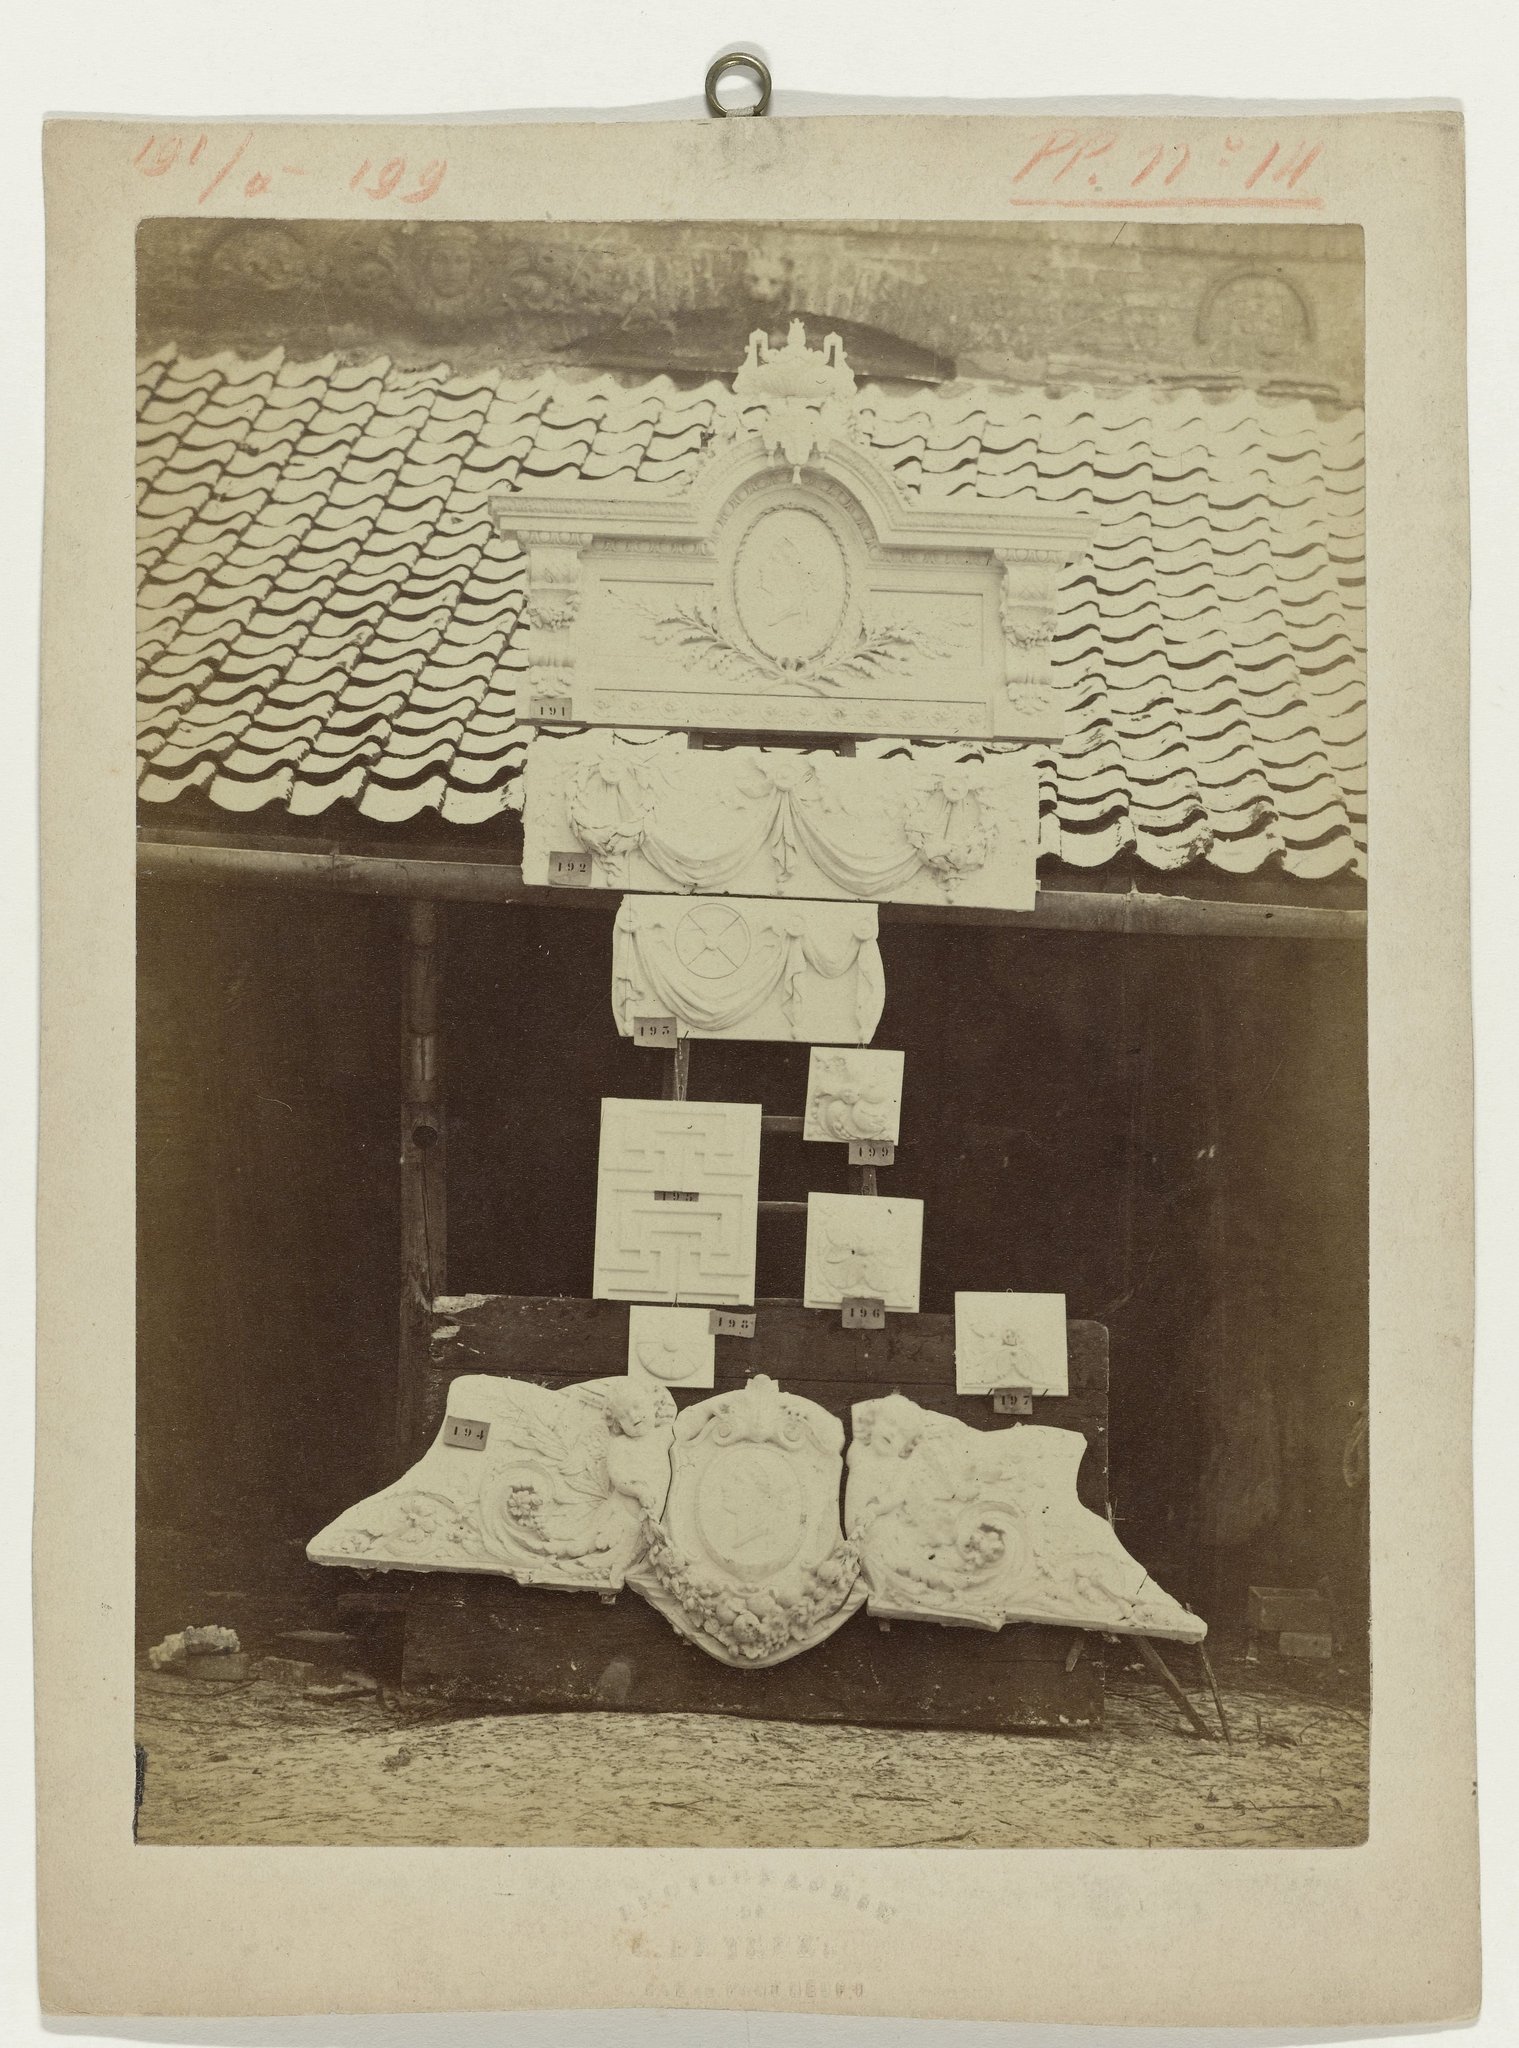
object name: photograph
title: Compositie van gipsen ornamenten uit het atelier van J. Delbove, Brussel, België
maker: charles de trez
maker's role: painter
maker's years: 1822-1899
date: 1860-1882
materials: cardboard, paper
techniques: albumen print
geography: brussels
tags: piece of sculpture, reproduction of a piece of sculpture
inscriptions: number, inscription, check stamp: ‘J.H DELBOVE/ Rue de Malines, 37/ BRUXELLES’, check stamp: ‘PHOTOGRAPHIE/ DE/ C. DE TREZ &/ RUE DU PONT NEUF 1’, inscription: ‘191 à 199 PP. No. 14’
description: Foto uit een incomplete serie van 13 foto's. Foto heeft sporen van een oogje aan de bovenzijde waaruit blijkt dat de foto gehangen heeft. Recto zijn nummers per voorwerp meegefotografeerd, corresponderend met een handgeschreven lijst die verso is geplakt.